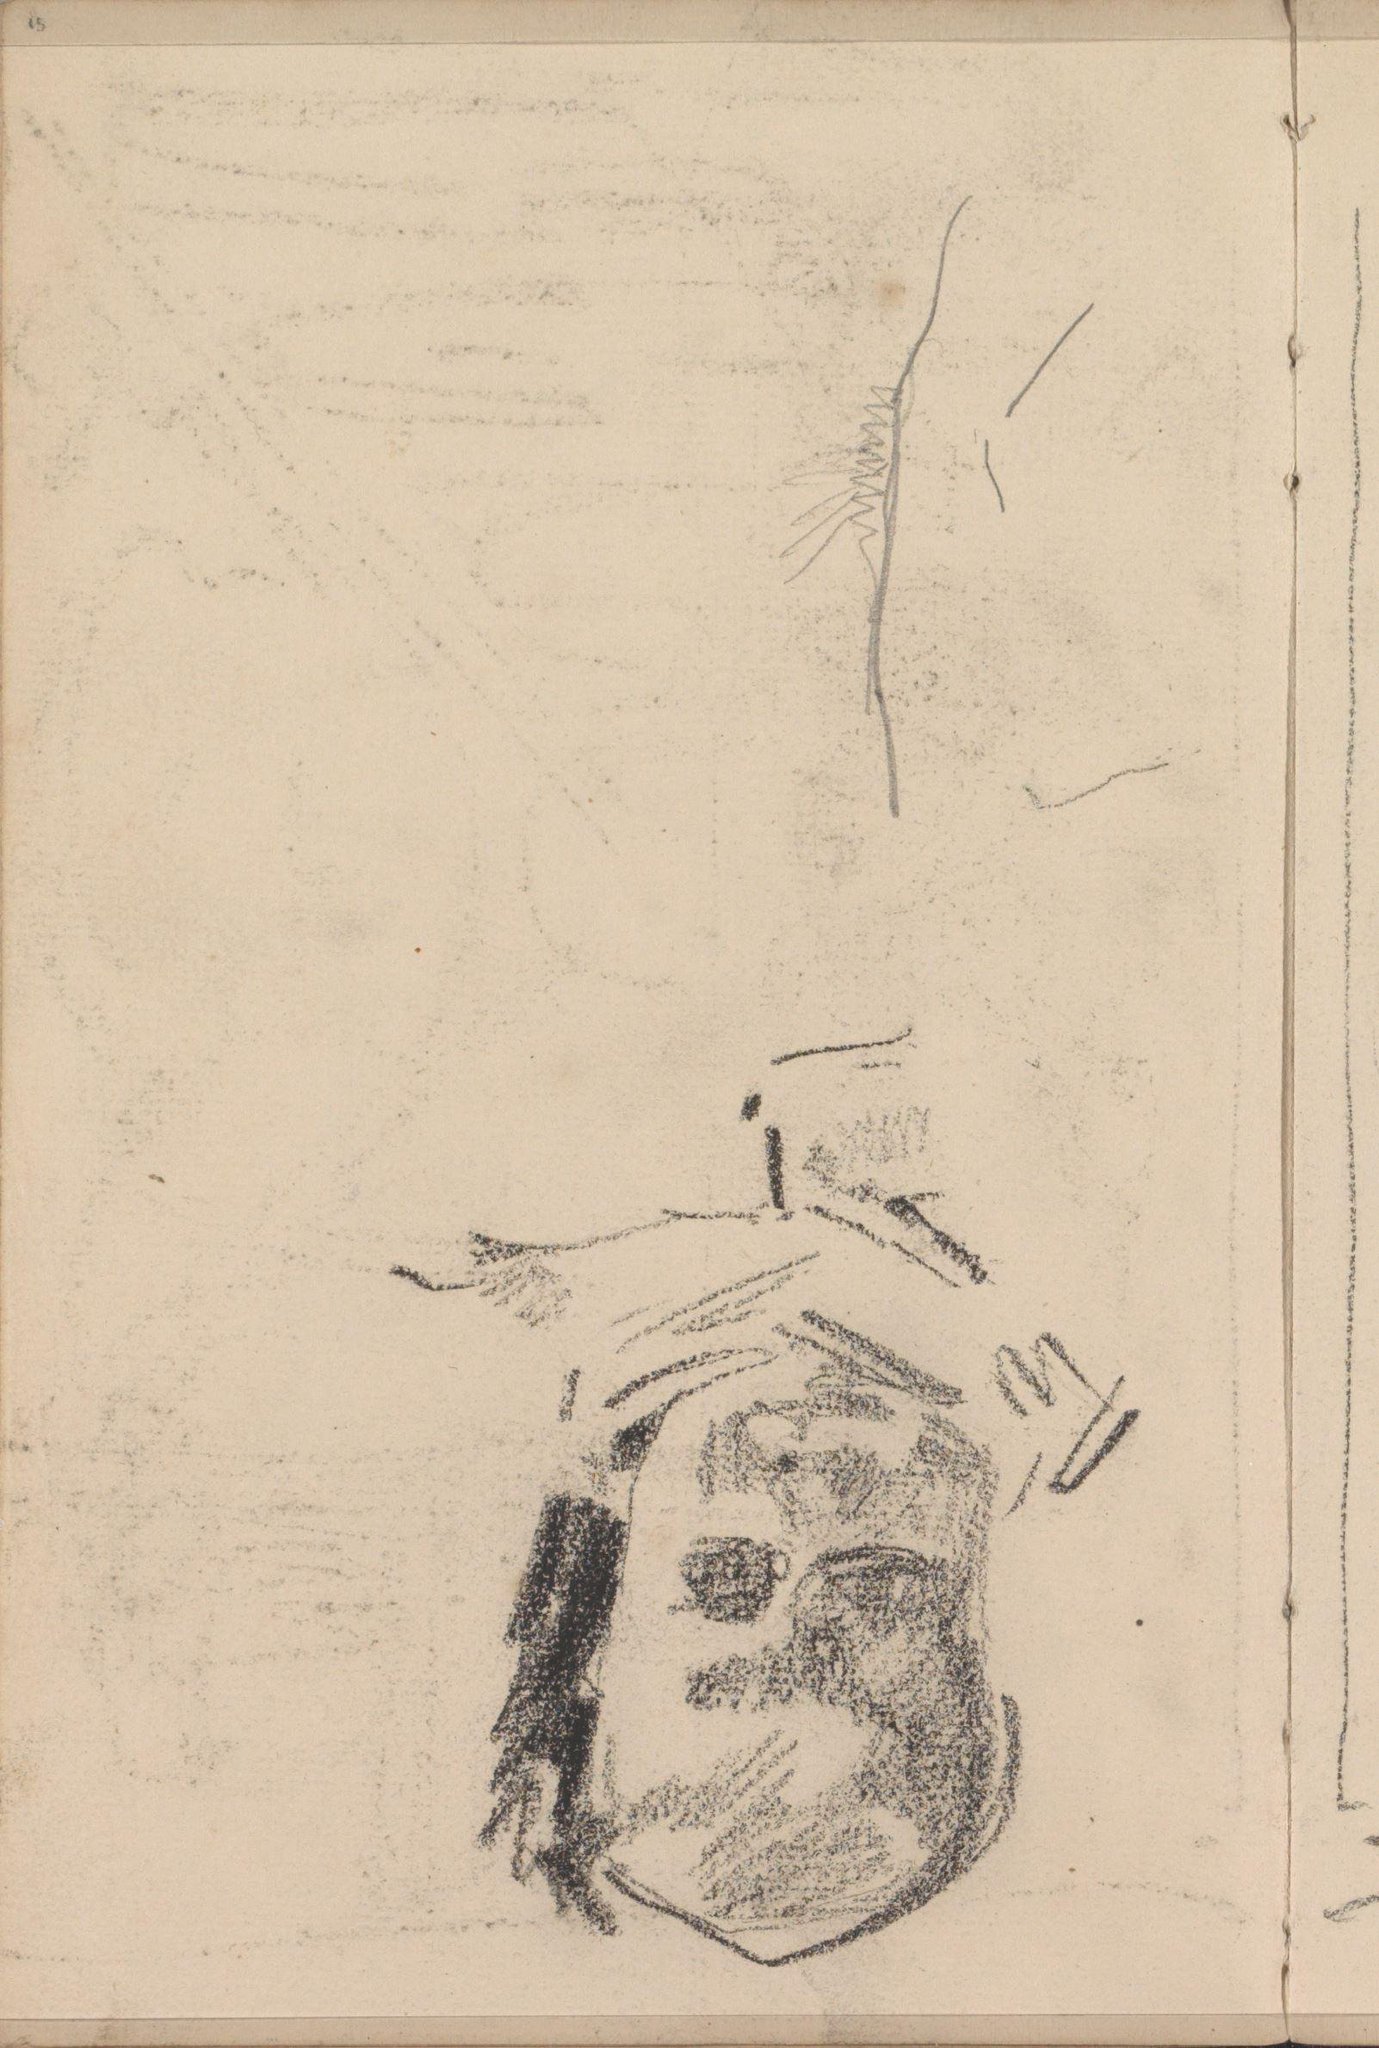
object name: sketchbook leaf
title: Kinderhoofd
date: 1881-1883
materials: chalk, paper, pencil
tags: head (human), child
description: Pagina 15 uit een schetsboek met 19 bladen.